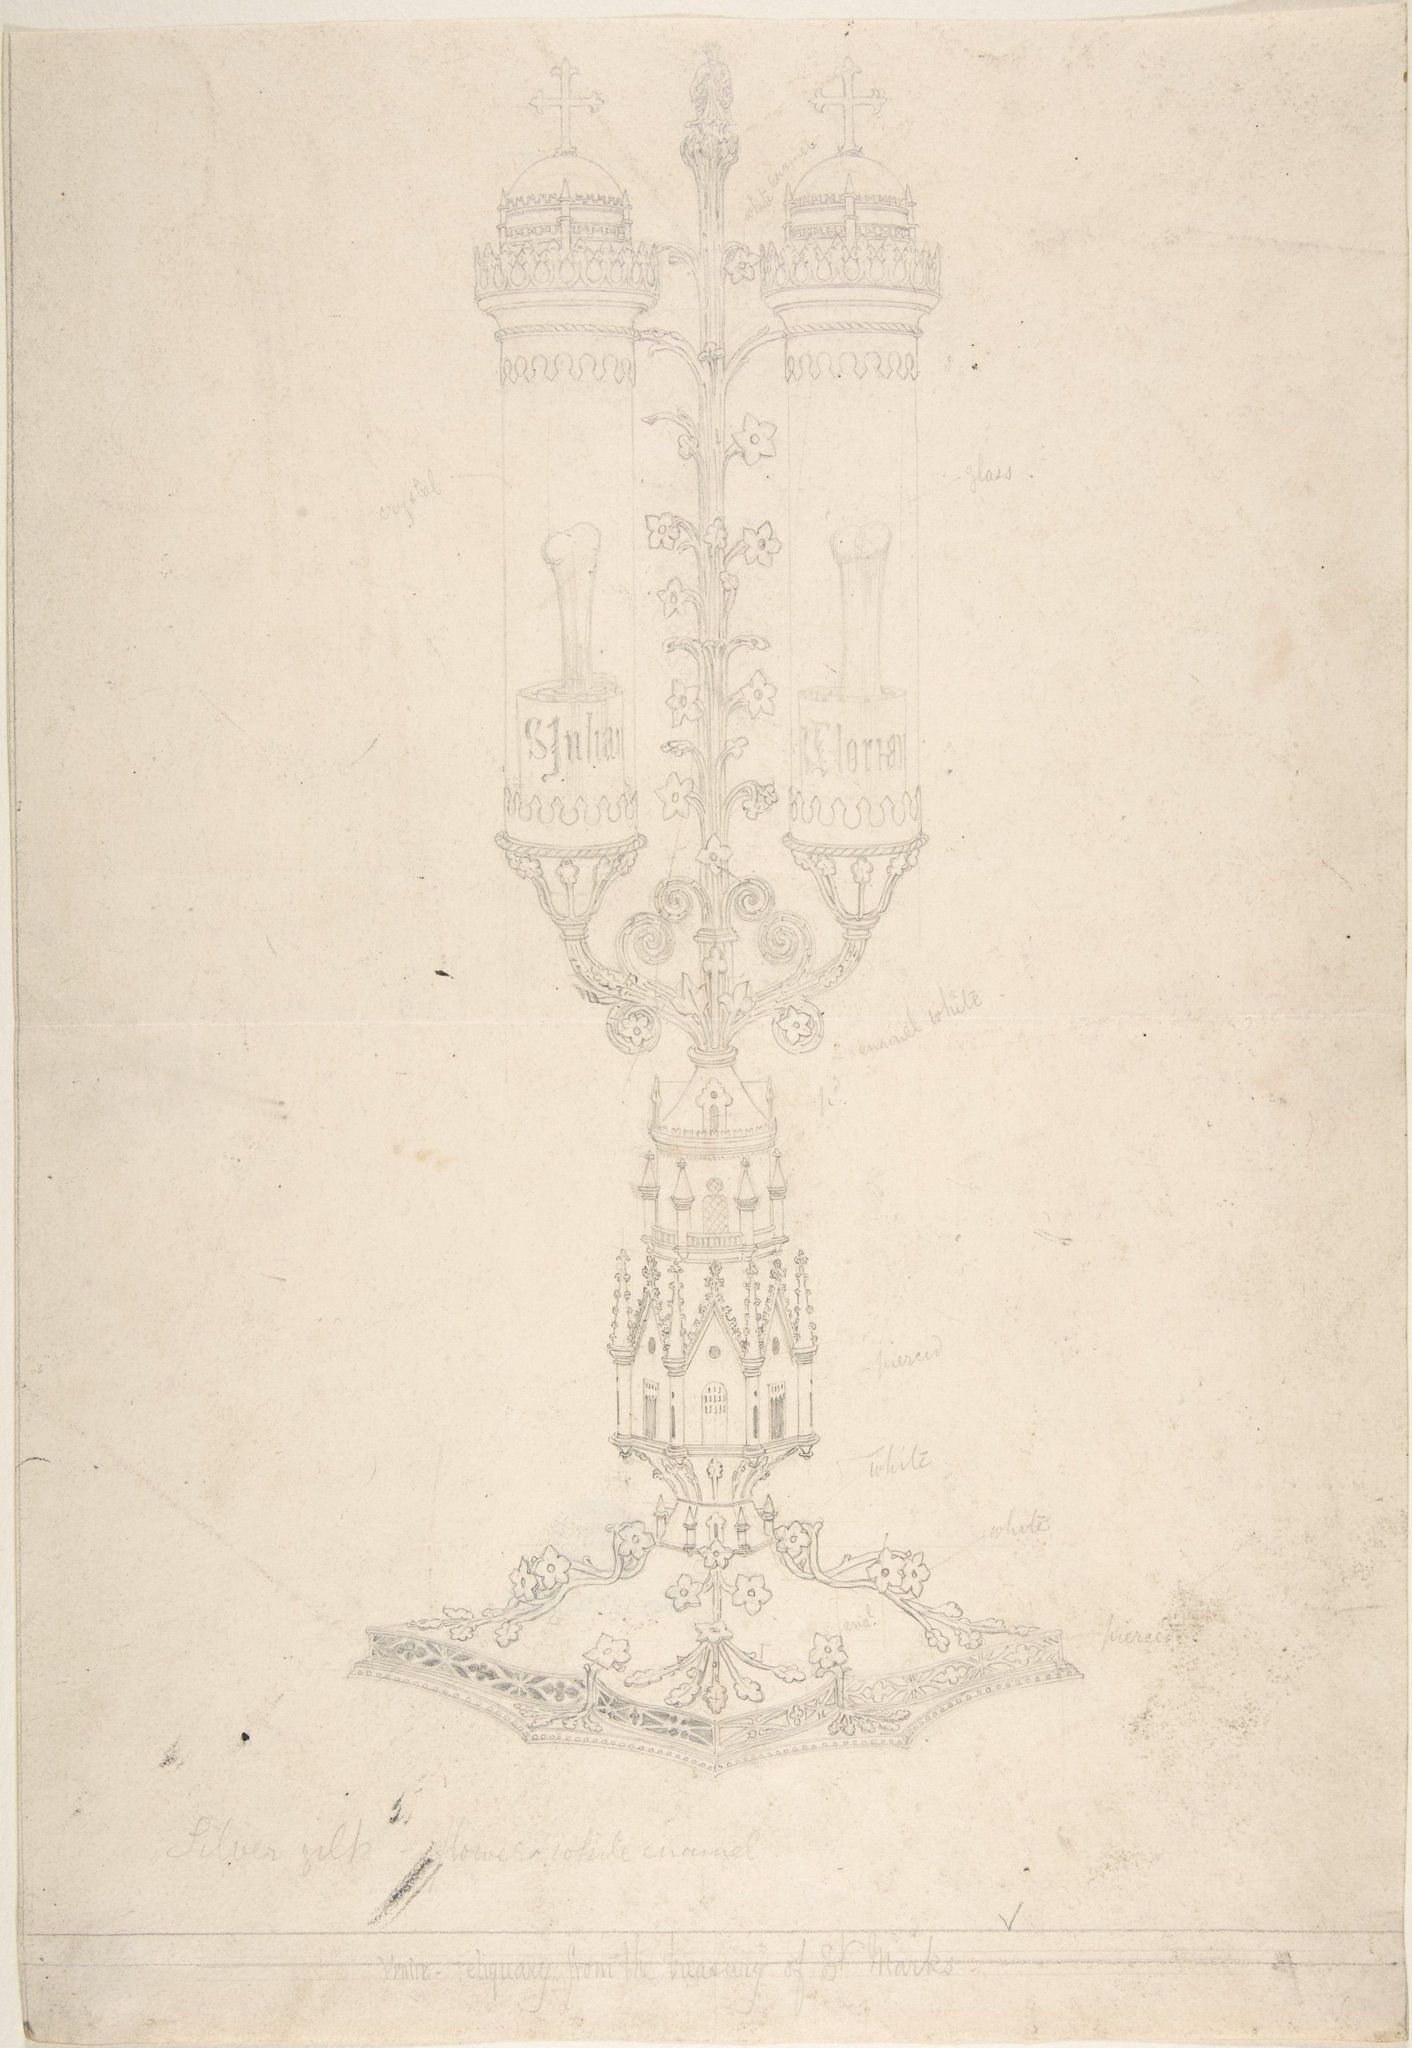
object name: drawing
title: Reliquary of Ss. Sylvan and Florian, from St. Mark's Venice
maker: anonymous, british, 19th century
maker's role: artist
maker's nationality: british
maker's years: 1800-1900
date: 1851-1900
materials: graphite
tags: reliquaries